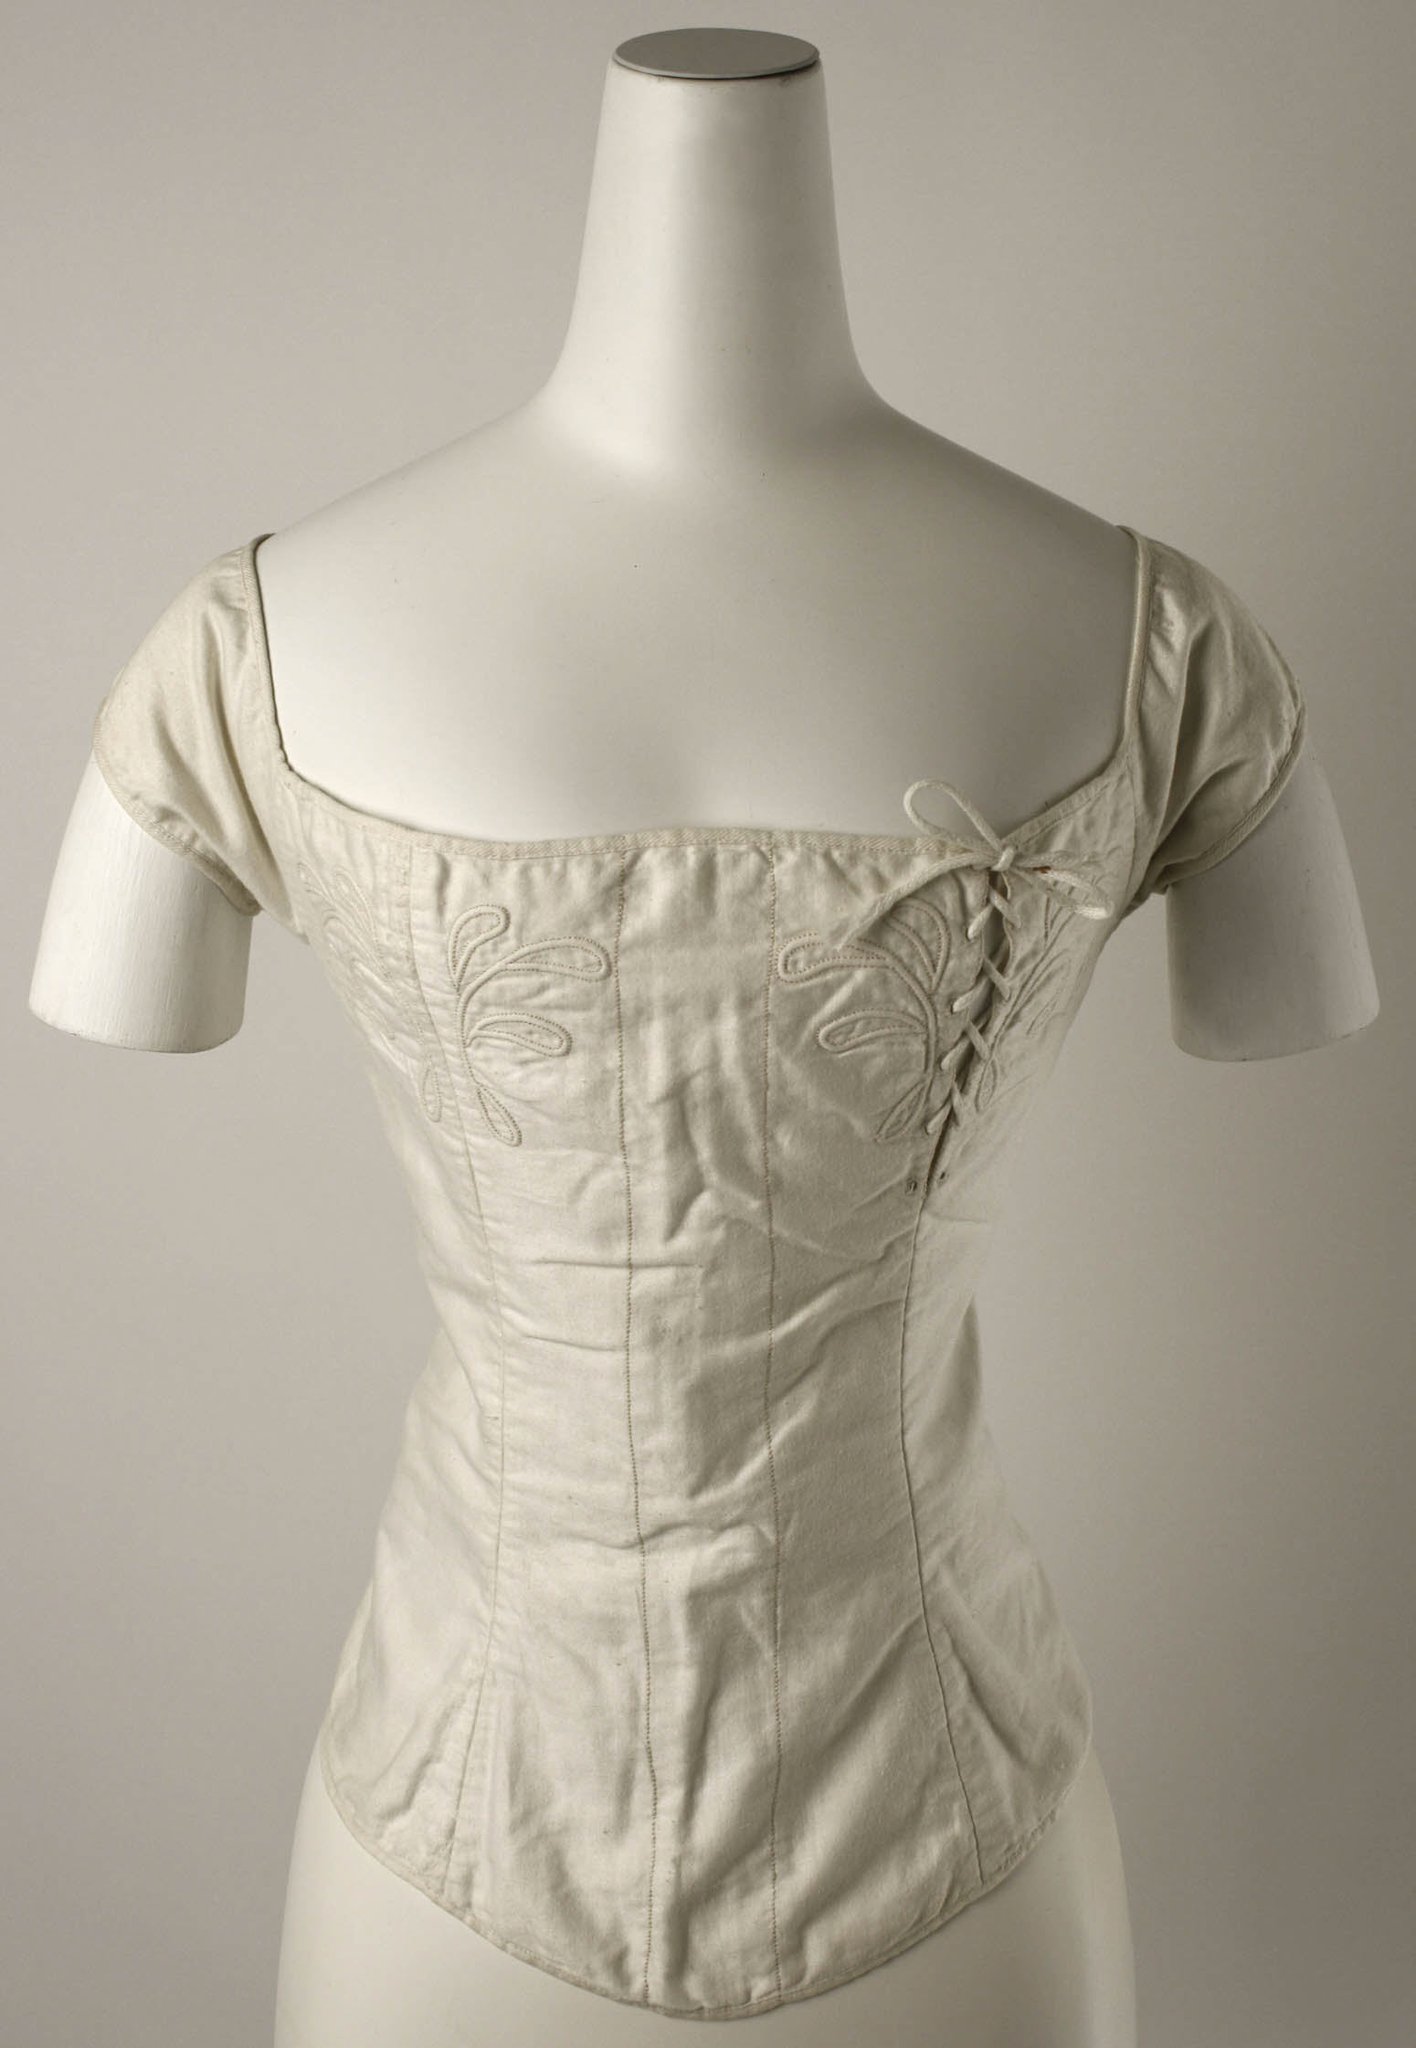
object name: corset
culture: american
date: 1820-1830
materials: cotton